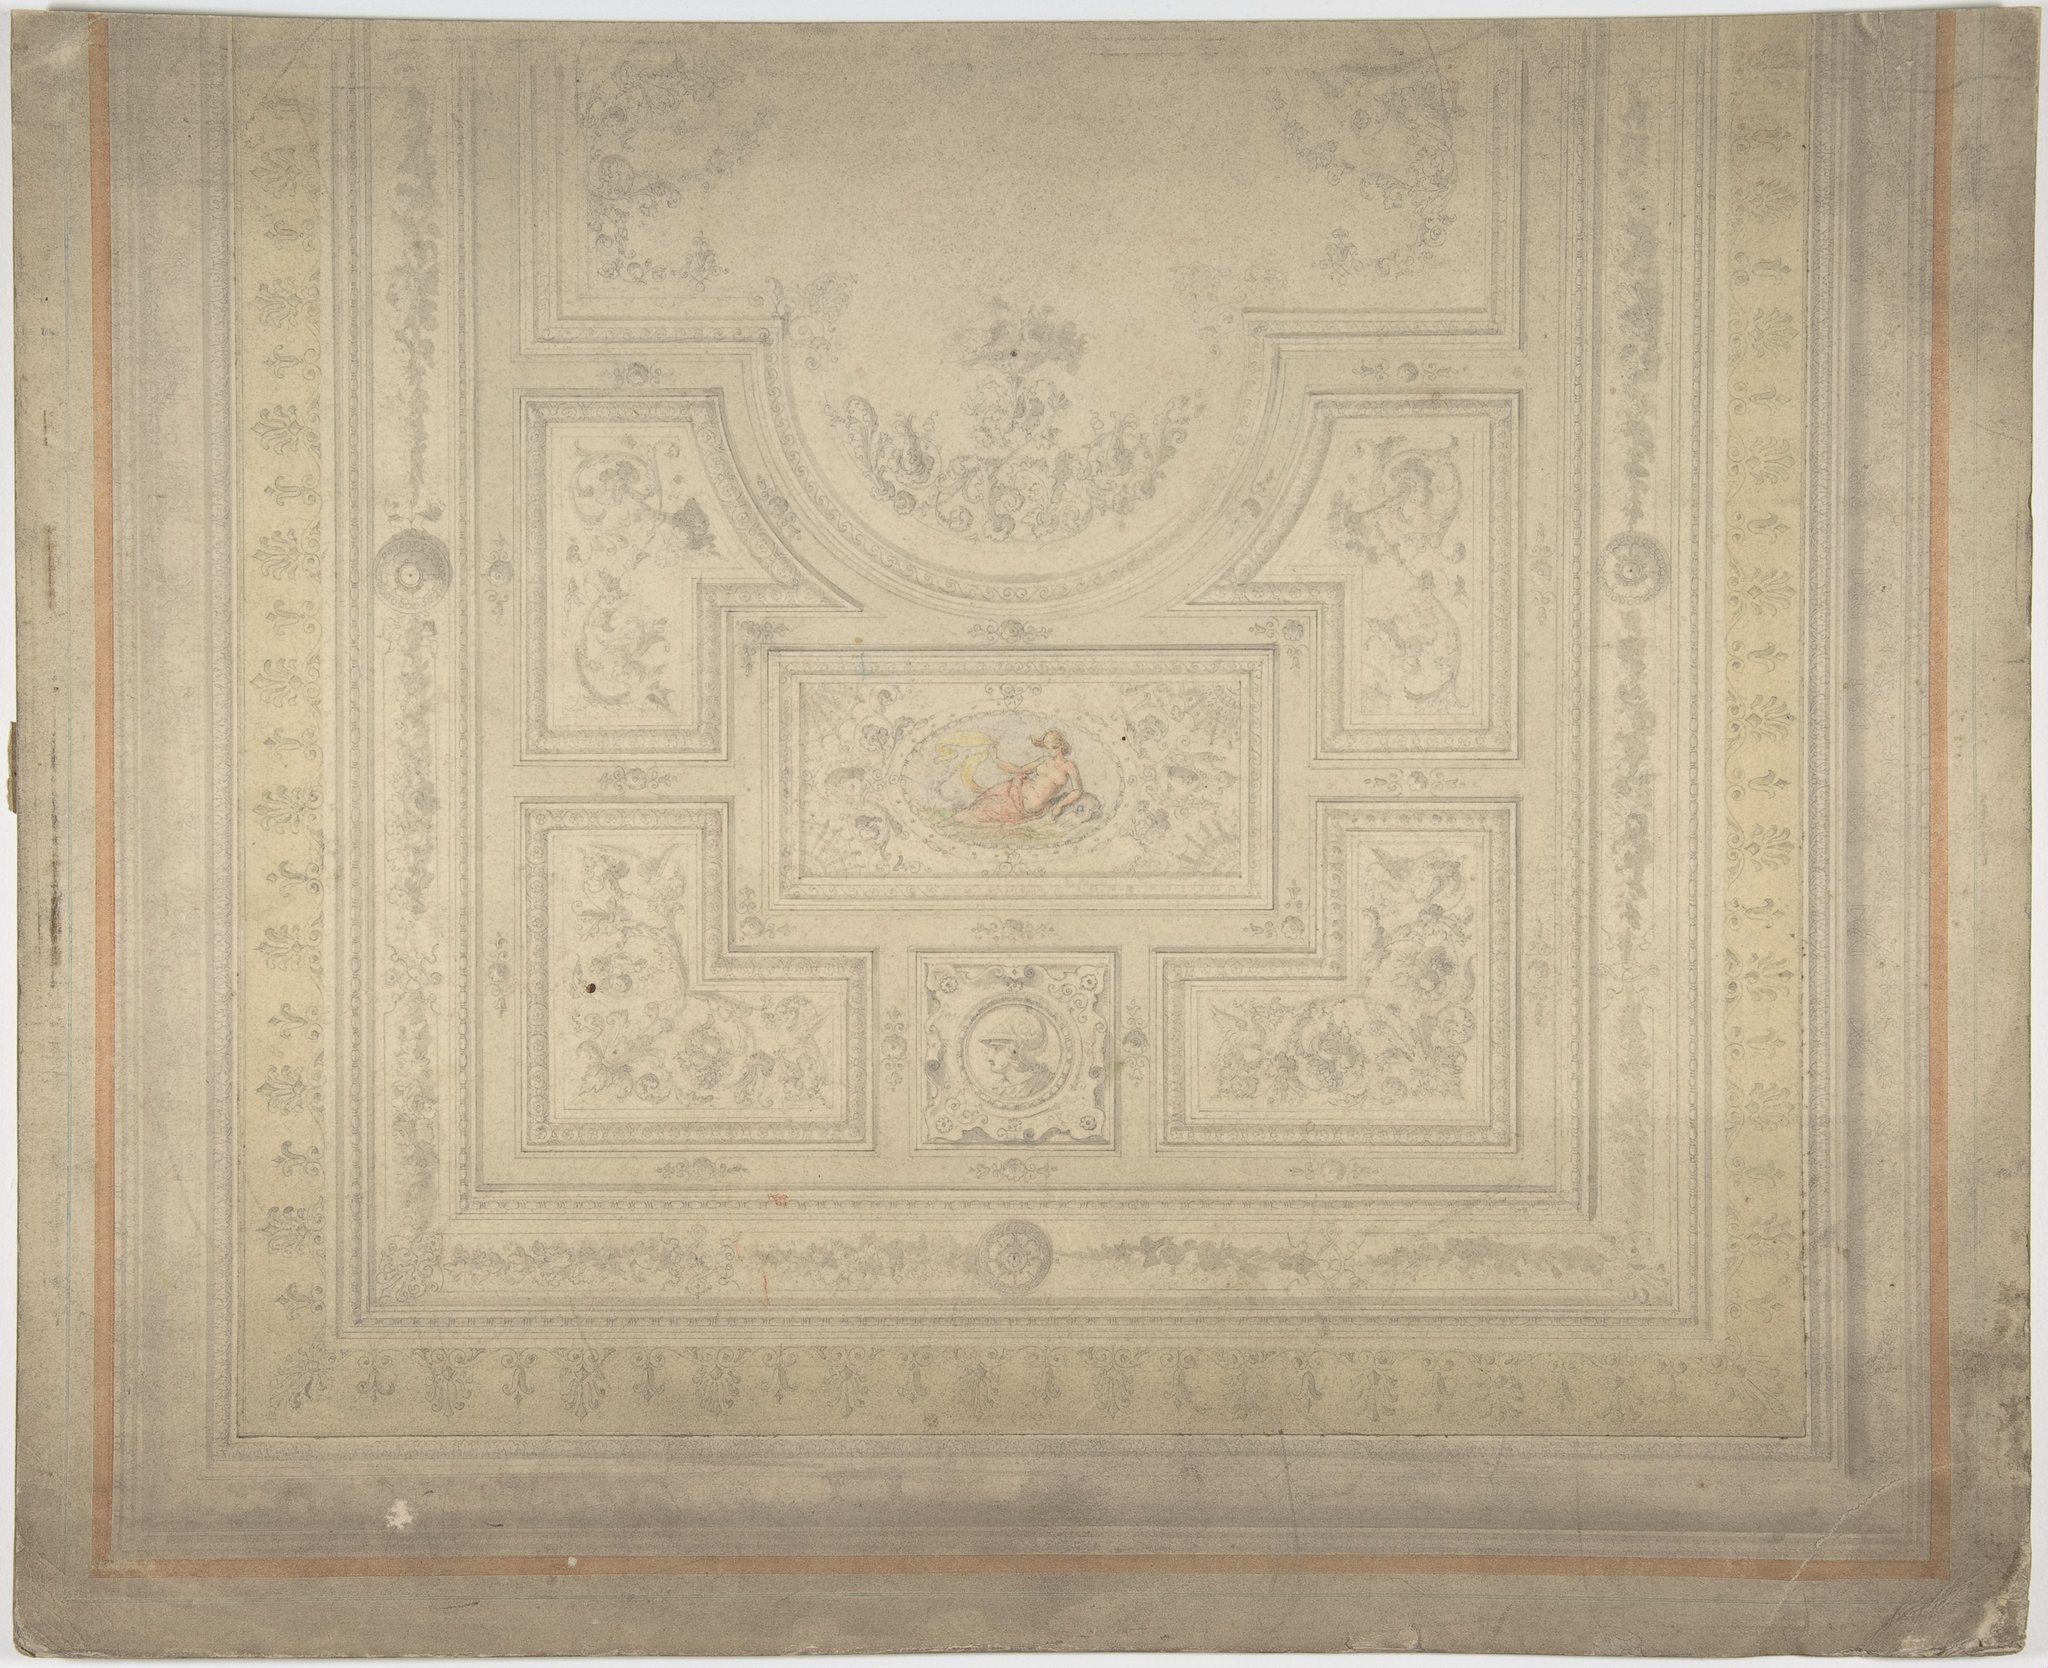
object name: drawing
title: Ceiling Design with Nymph on Dolphin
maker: anonymous, british, 19th century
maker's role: artist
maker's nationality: british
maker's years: 1800-1900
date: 1801-1900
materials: ink, watercolor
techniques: pen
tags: nymphs,dolphins,ceilings